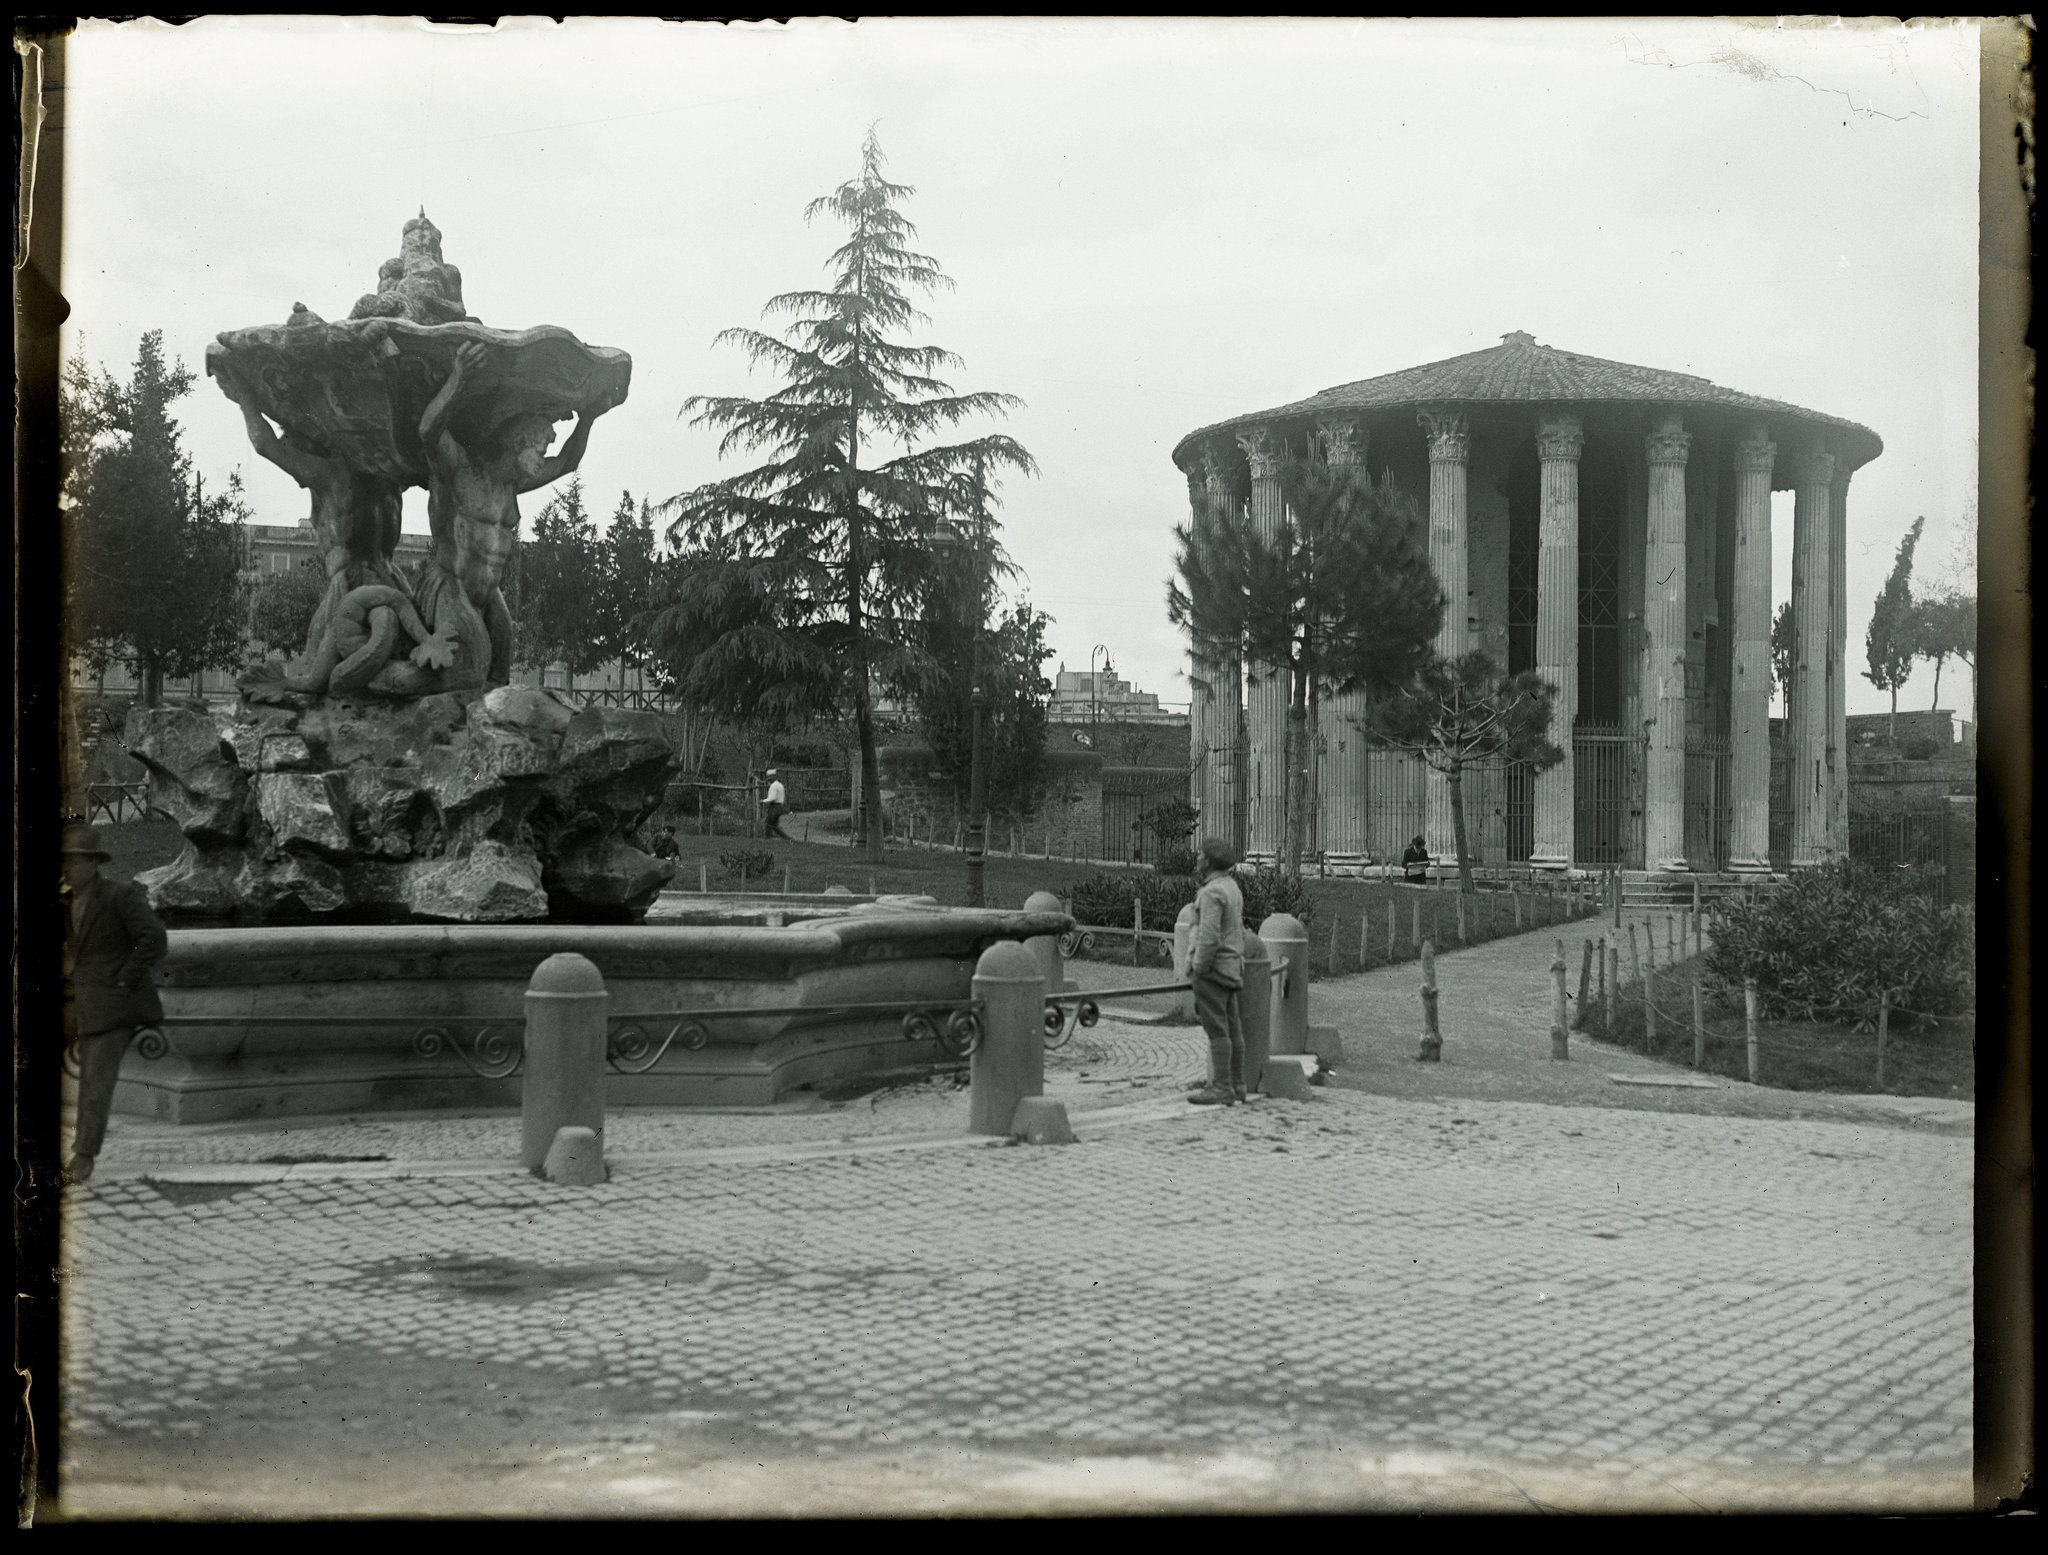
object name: glasnegatief, glasplaatnegatief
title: Tempel van Hercules Victor en de Fontana dei Tritoni op het Piazza della Bocca della Verità te Rome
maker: Anonymous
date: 1907-1935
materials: glass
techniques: gelatin glass negative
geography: rome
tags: ruin of a building ~ architecture, temple, shrine ~ roman religion, ornamental fountain